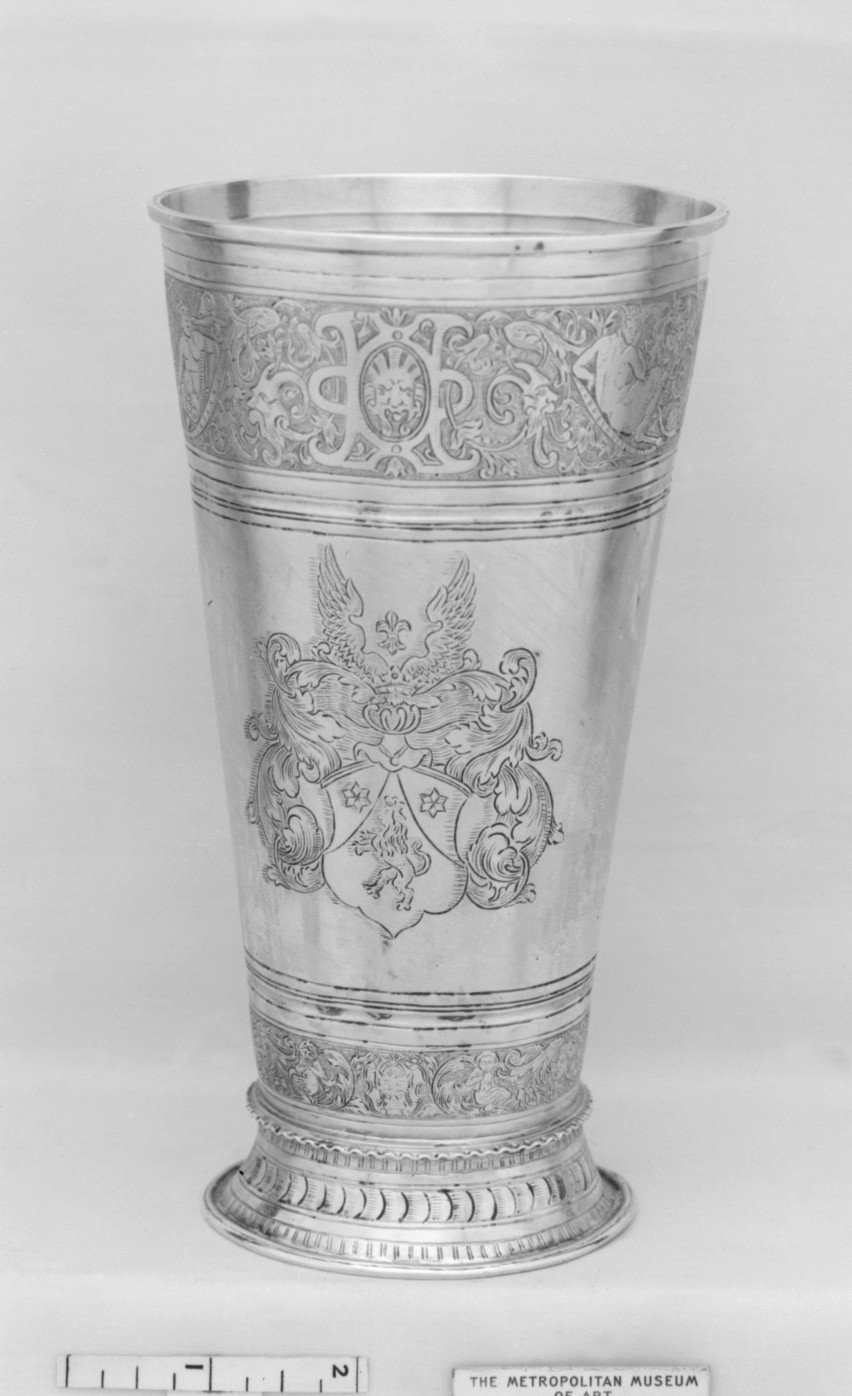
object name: beaker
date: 1801-1900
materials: silver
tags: coat of arms